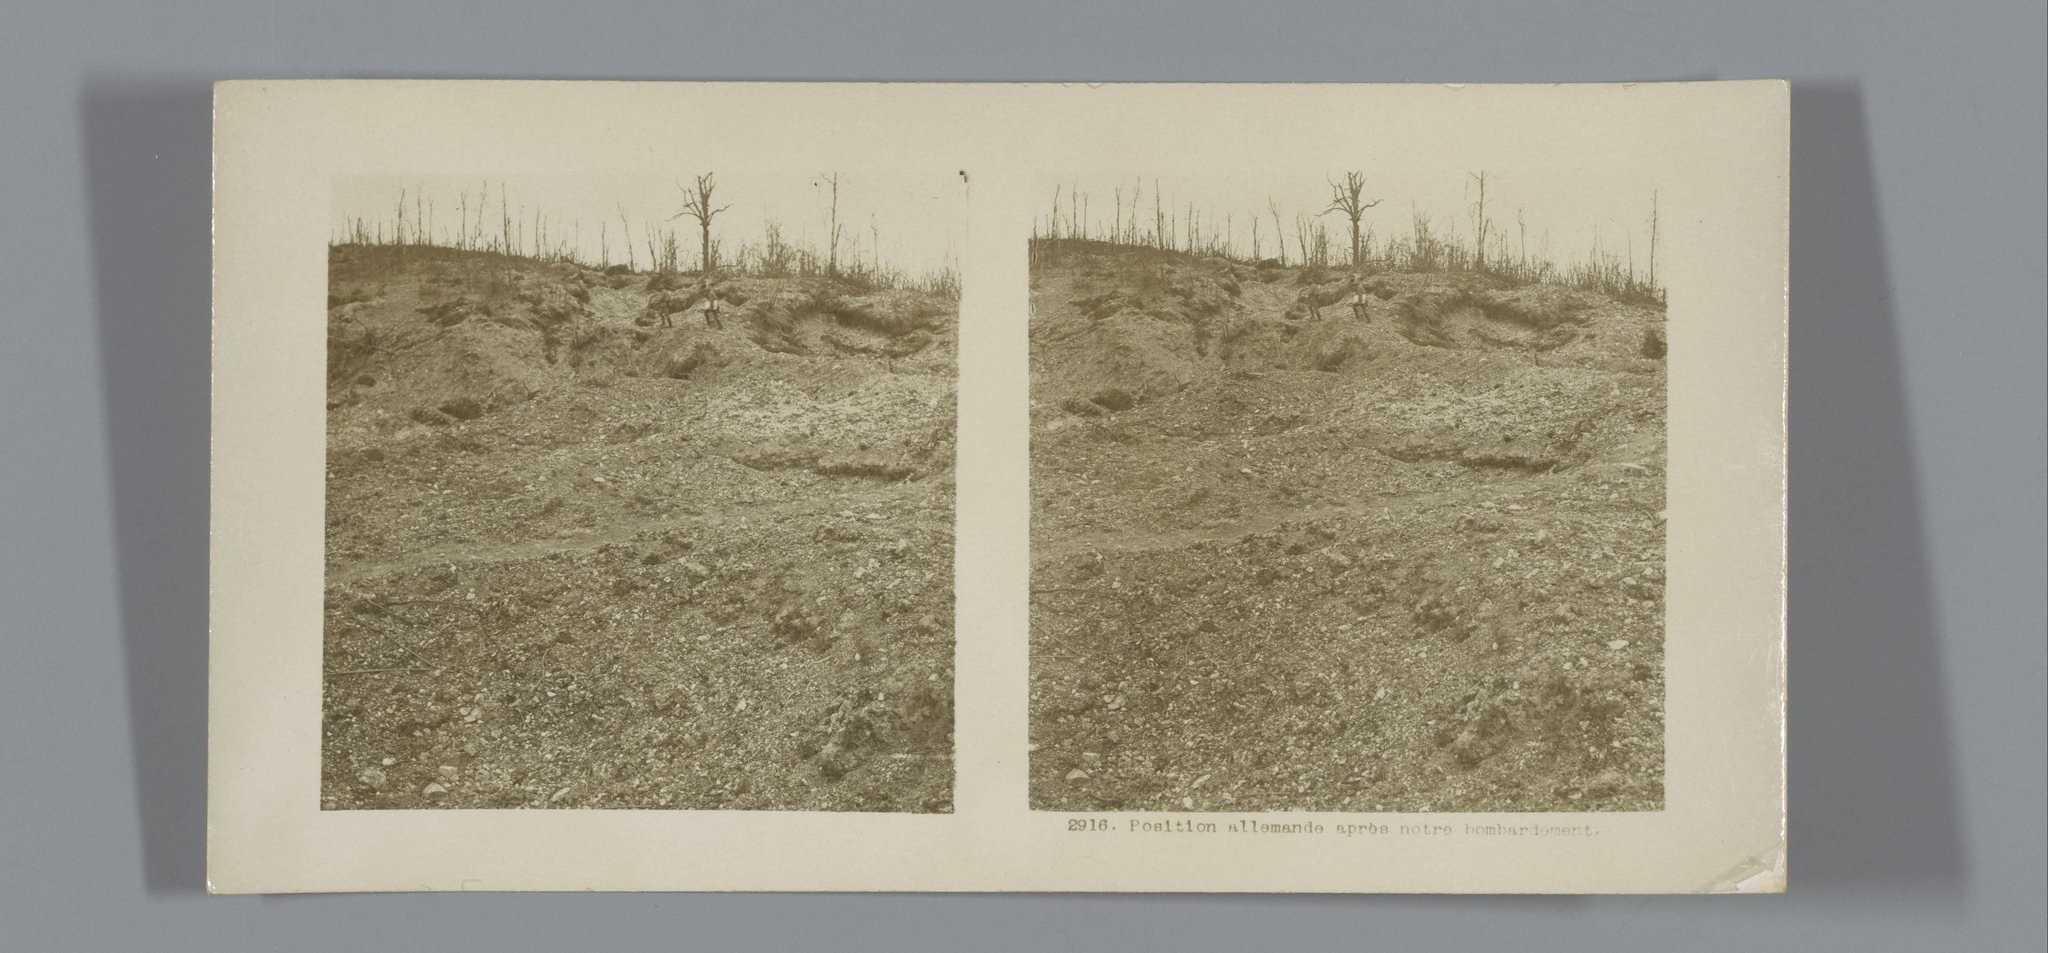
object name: stereograph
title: Position allemande apres notre bombardement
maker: Anonymous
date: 1914-1918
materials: cardboard, photographic support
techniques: gelatin silver print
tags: environmental destruction, firearms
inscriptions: number: ‘2916.’